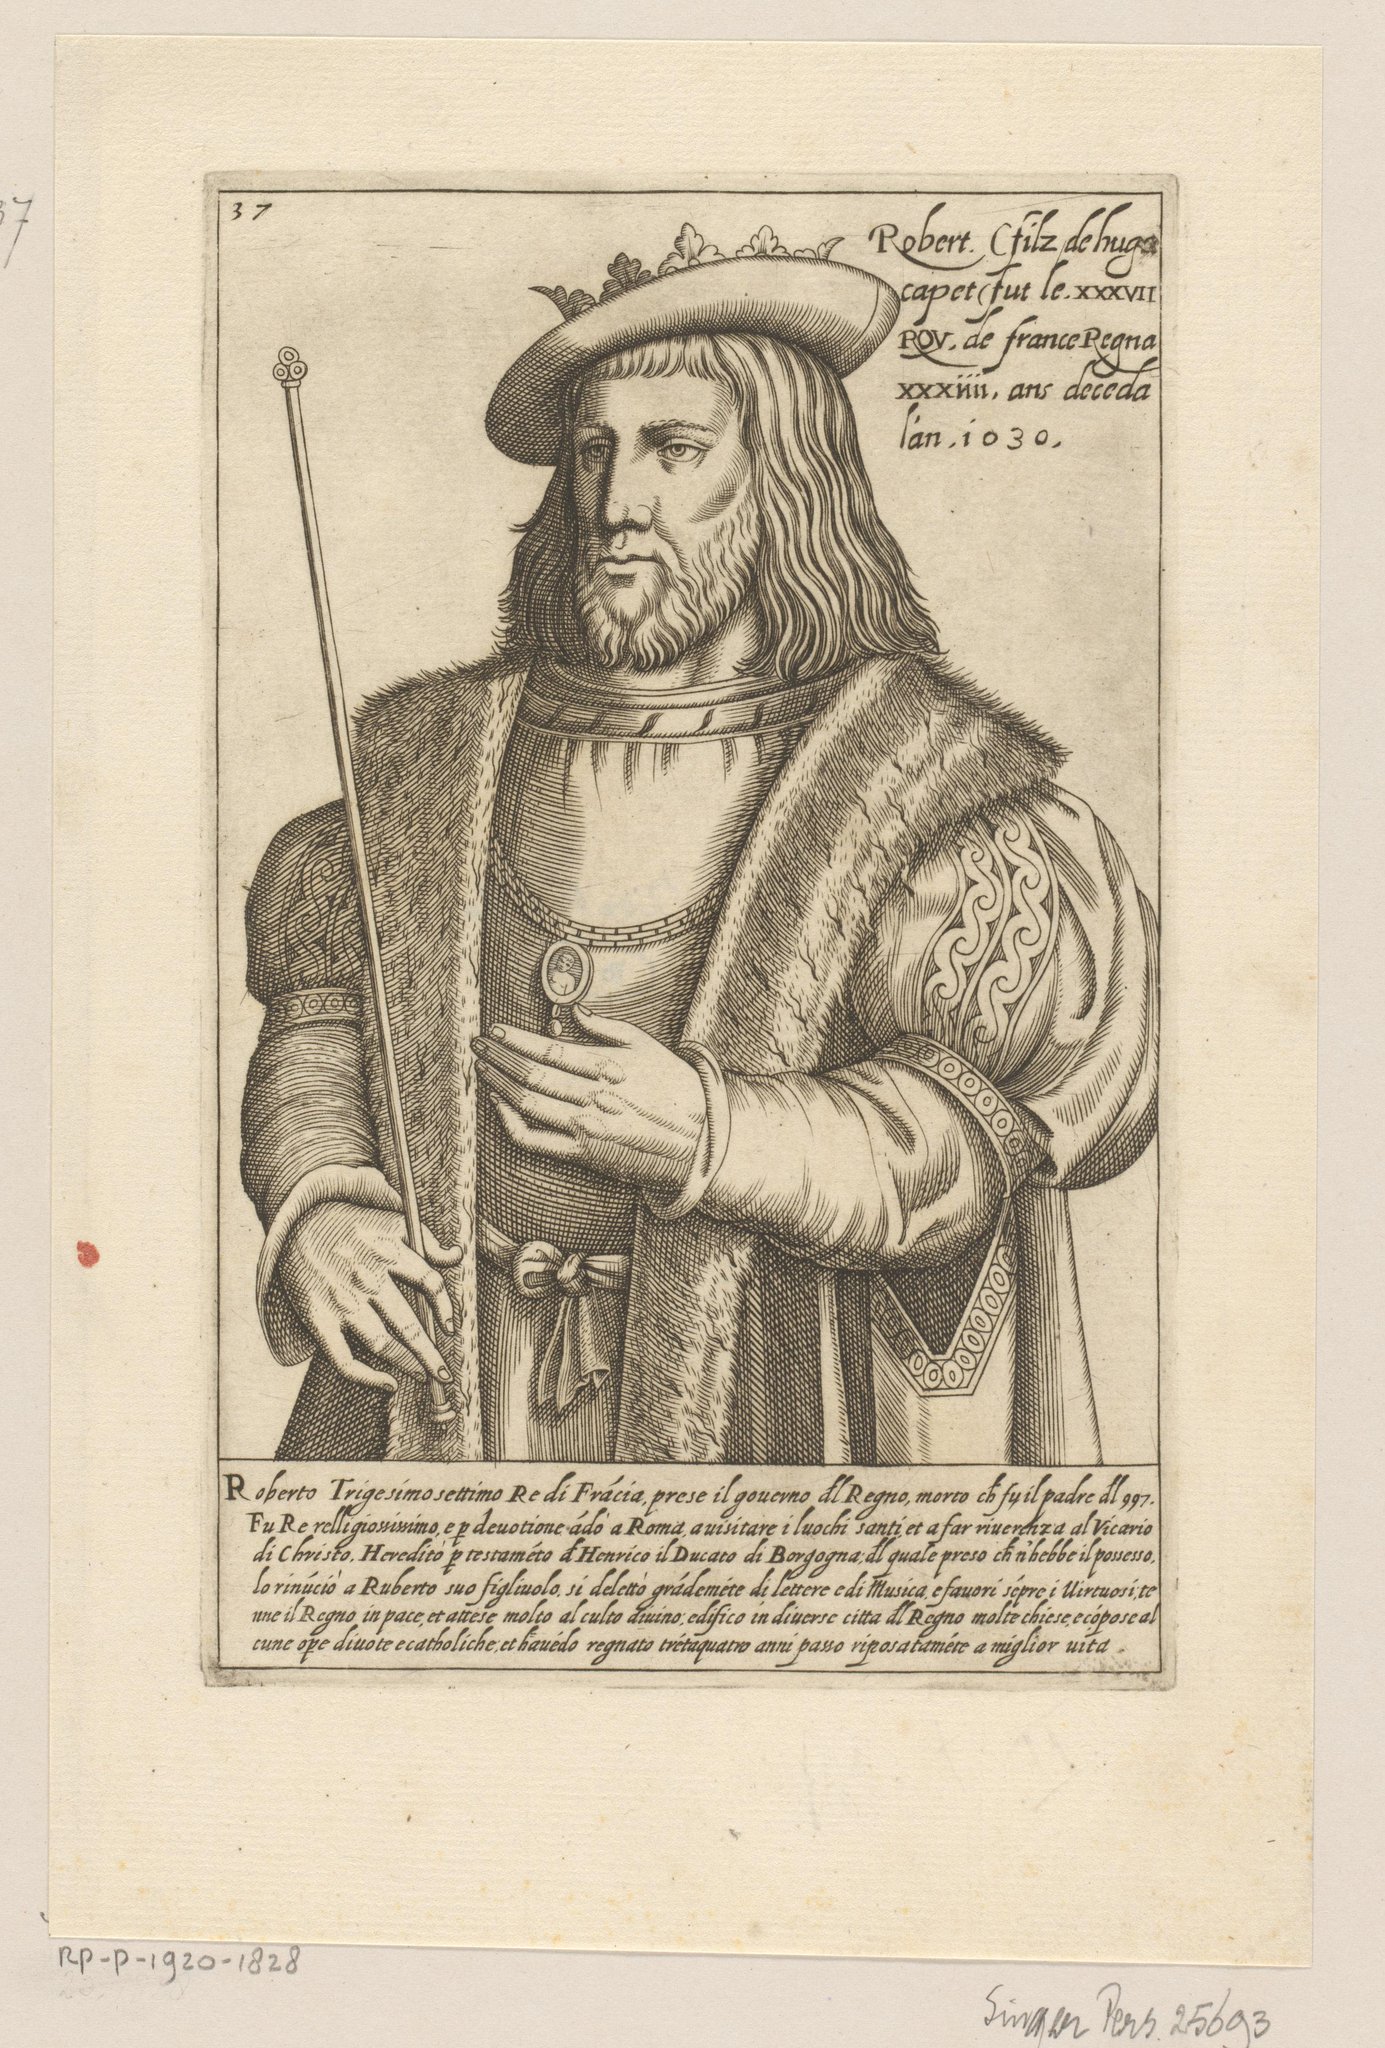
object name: print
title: Portret van Robert II de Vrome, koning van Frankrijk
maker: Anonymous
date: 1588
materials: paper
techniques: engraving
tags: crown (symbol of sovereignty), sceptre, staff (symbol of sovereignty), historical persons, king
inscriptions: collector's mark: Lugt 2228, watermark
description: Prent voor het eerst gebruikt in: Cronica Breve de i fatti illustri de're di Francia, con le loro effigie dal naturale cominciando da Faramondo (...). Venetië: Bernardo Giunti, 1588. Prent in ieder geval ook gebruikt in de editie van 1590 en mogelijk ook in een Franse uitgave van 1597.